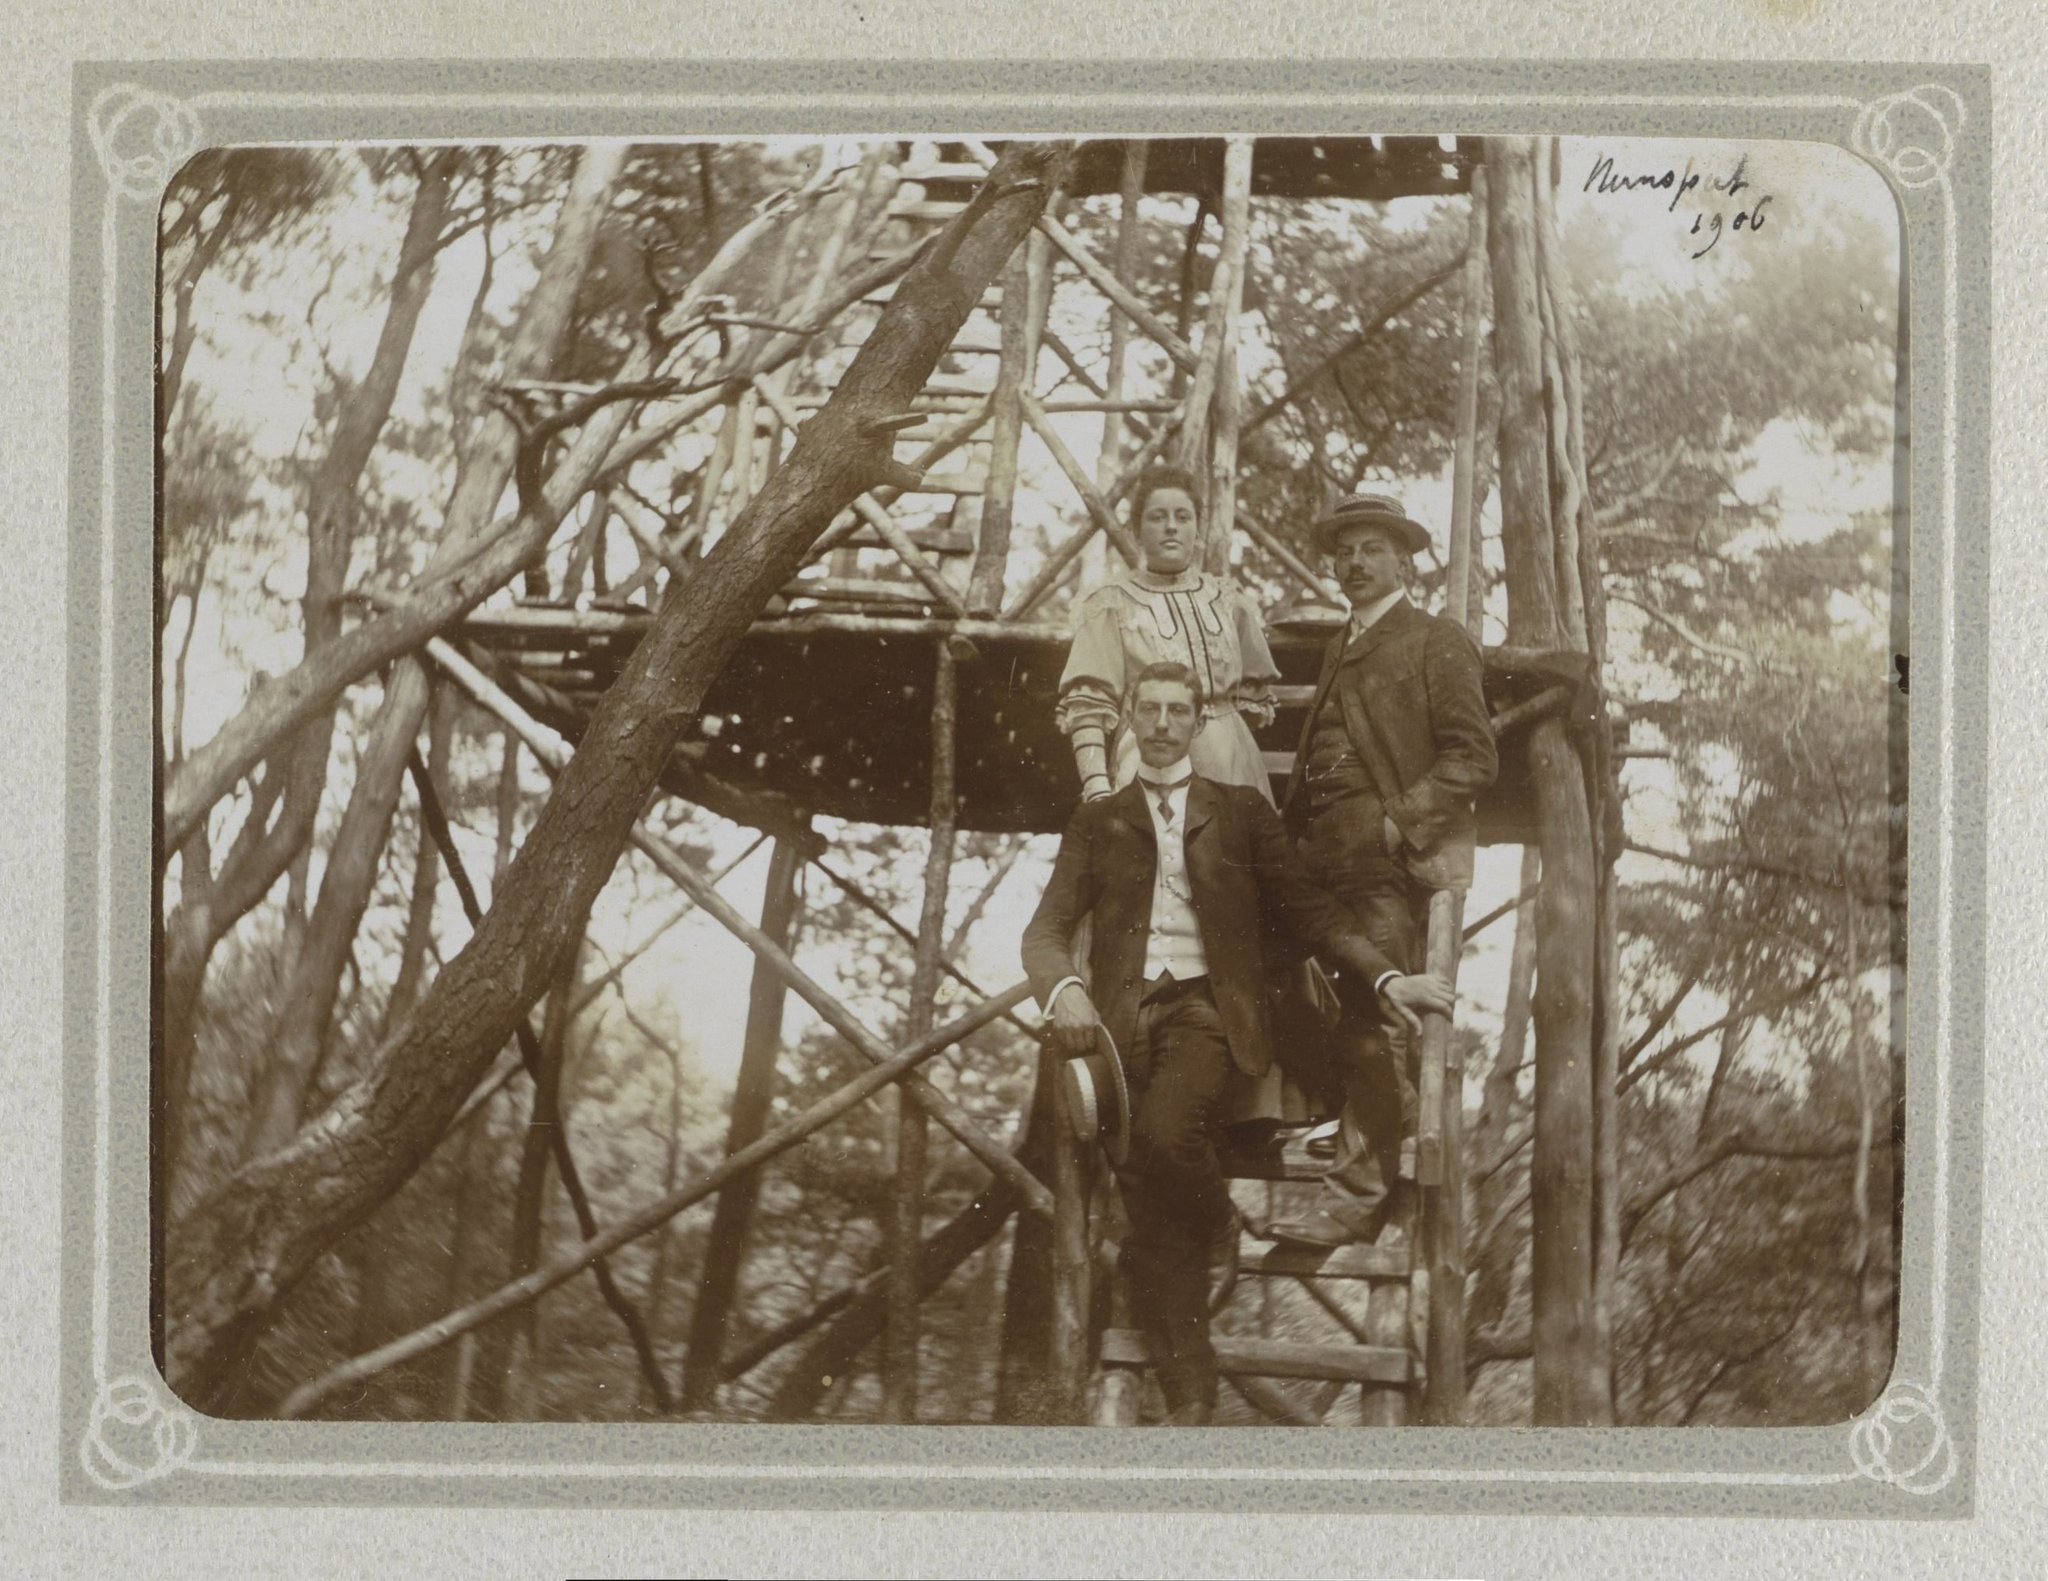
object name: photograph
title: Nunspeet 1906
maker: folkert idzes de jong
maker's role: architect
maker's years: 1877-1929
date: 1906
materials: photographic support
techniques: collodion silver print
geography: nunspeet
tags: historical persons not known by name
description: Onderdeel van Topografisch album van Nederlandse dorpen en steden 1905.